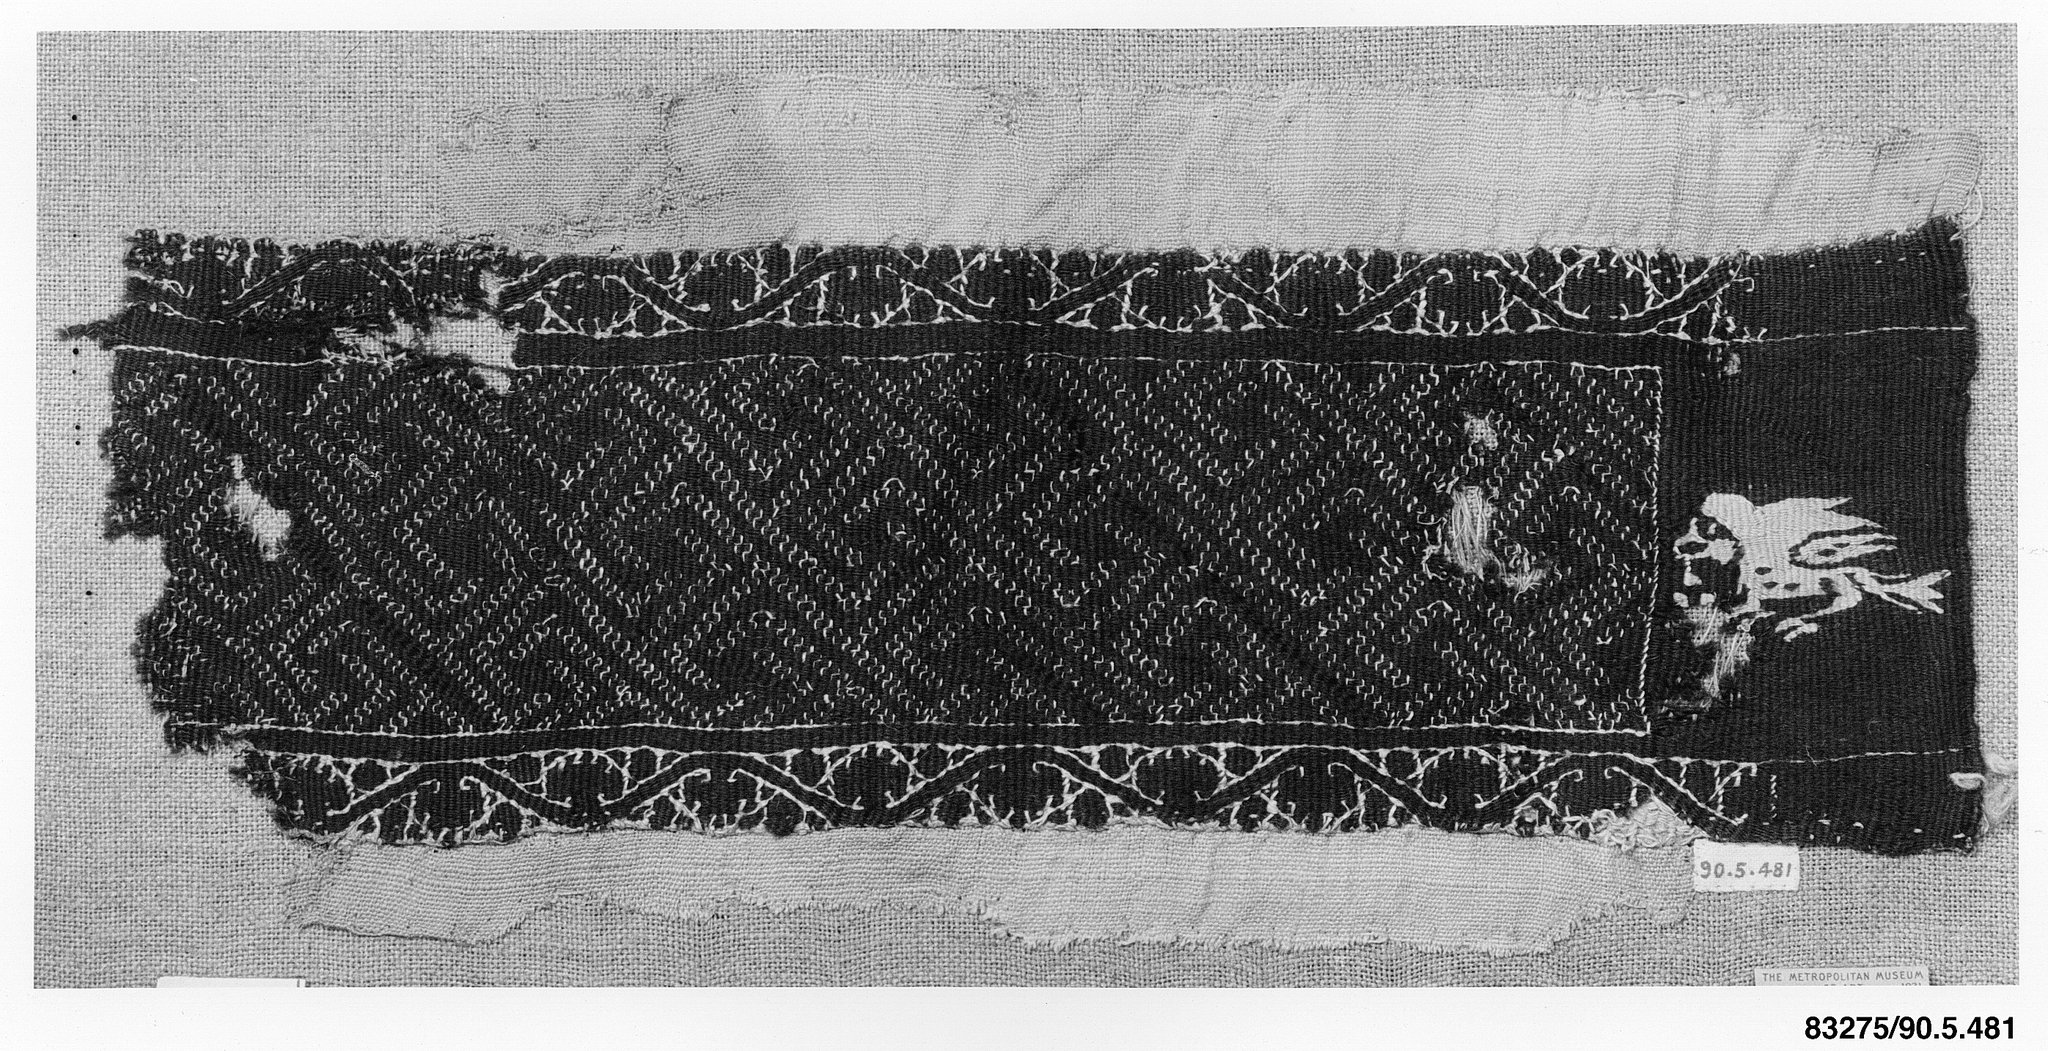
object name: textile fragment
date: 201-400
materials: linen, wool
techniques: weave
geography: egypt